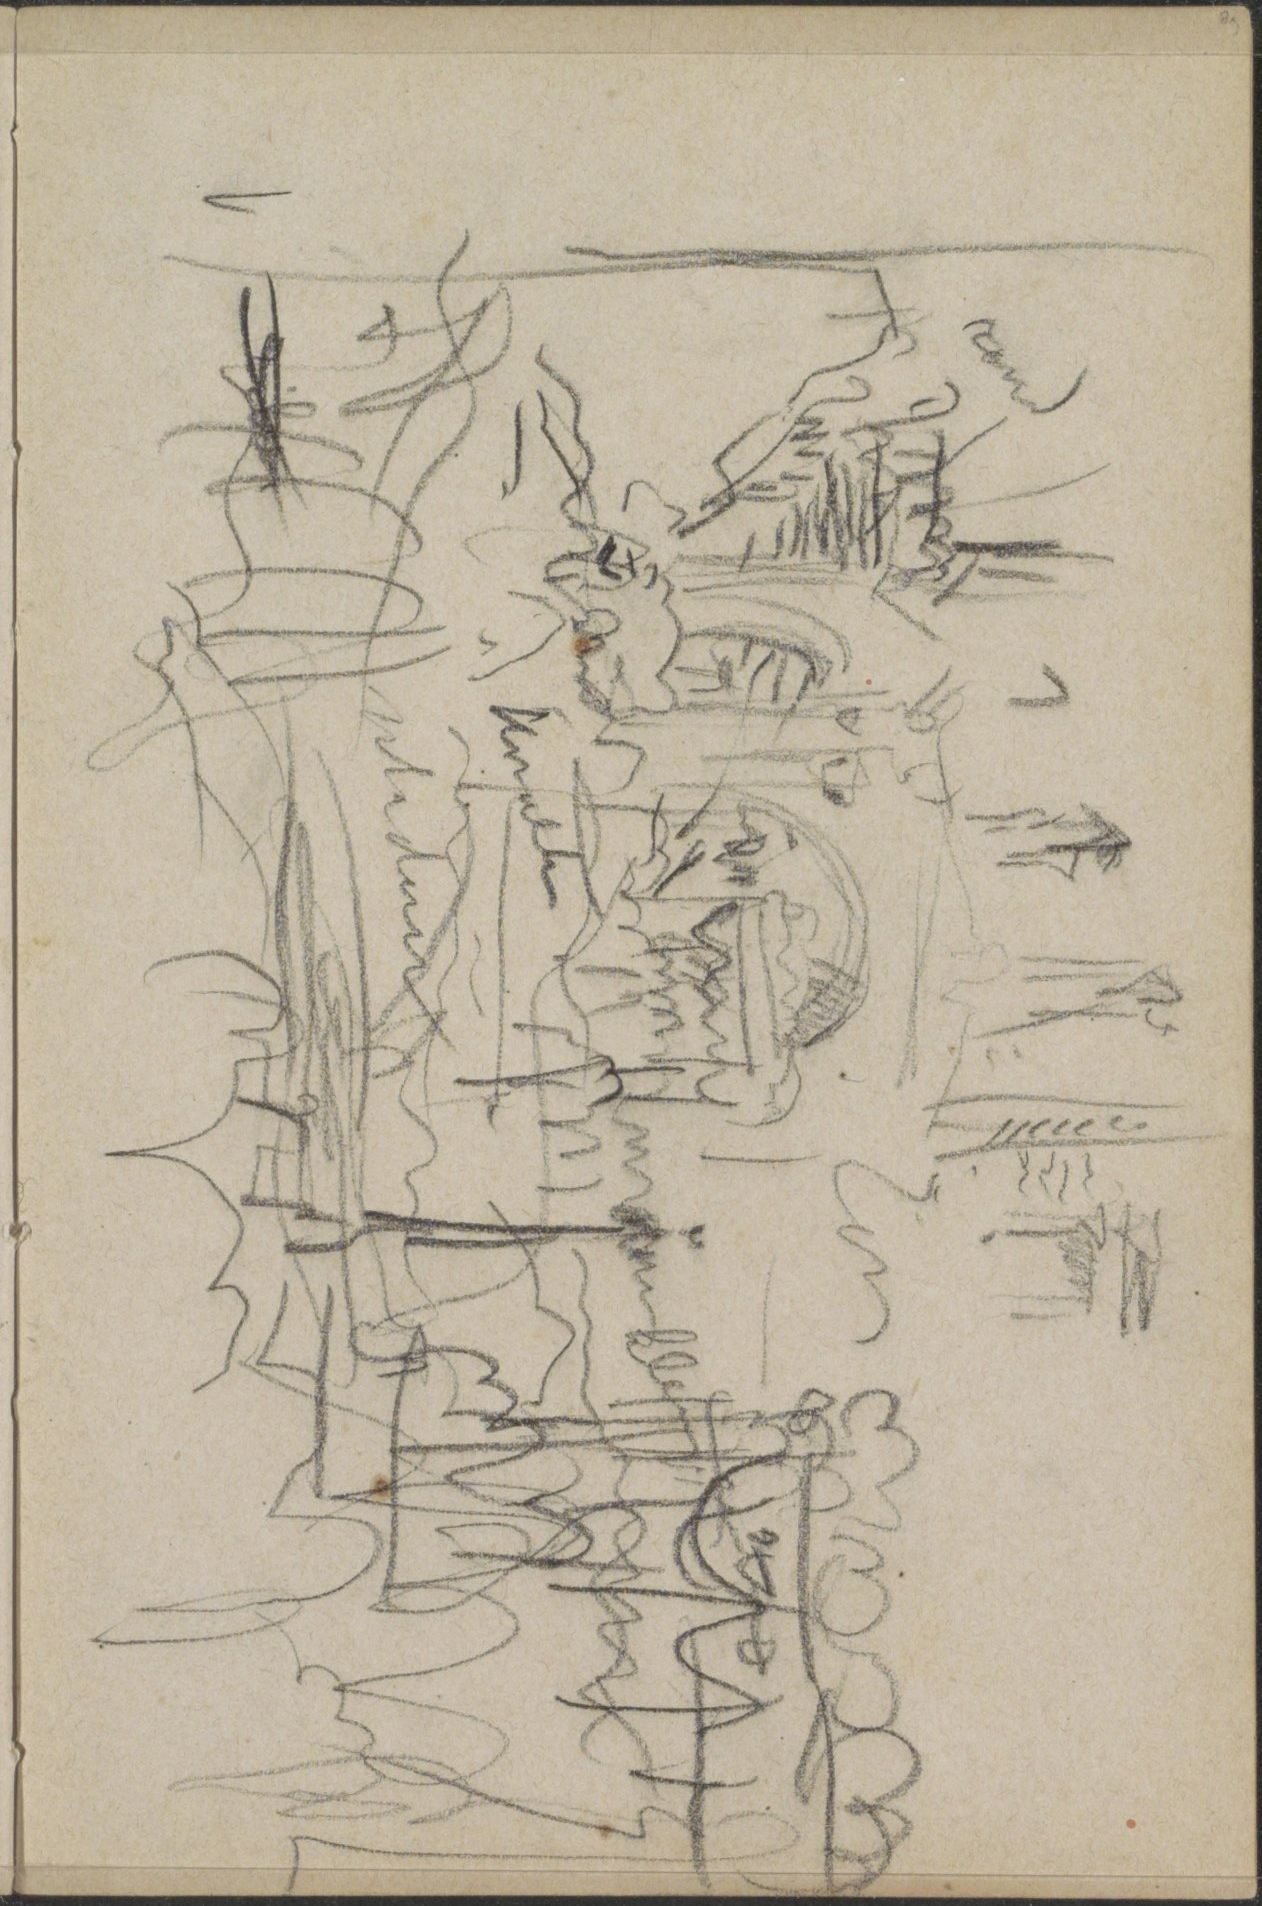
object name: sketchbook leaf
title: Processie met een baldakijn bij de trap van het Granovitaya Palata te Moskou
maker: marius bauer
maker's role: draughtsman, print maker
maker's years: 1867-1932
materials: chalk, paper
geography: moscow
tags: coronation procession, flight of steps, canopy, baldachin, palace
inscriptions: kleurnotitie, handgeschreven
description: De trap en veranda maakten deel uit van de route van de processie voor de kroning van tsaar Nicolaas II. Pagina 89 uit een schetsboek met 54 bladen.